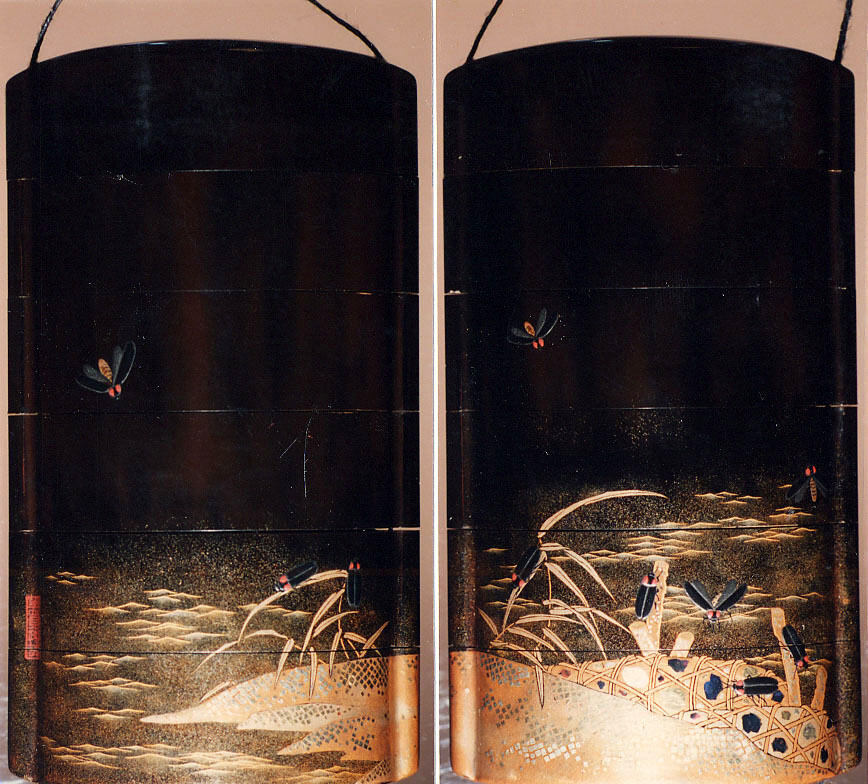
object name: inrō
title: Case (Inrō) with Design of Fireflies in Flight and Climbing on Stone Baskets and Reeds at the Shore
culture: japanese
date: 1801-1900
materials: gold, lacquer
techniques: fundame, hiramakie, roiro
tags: insects,plants